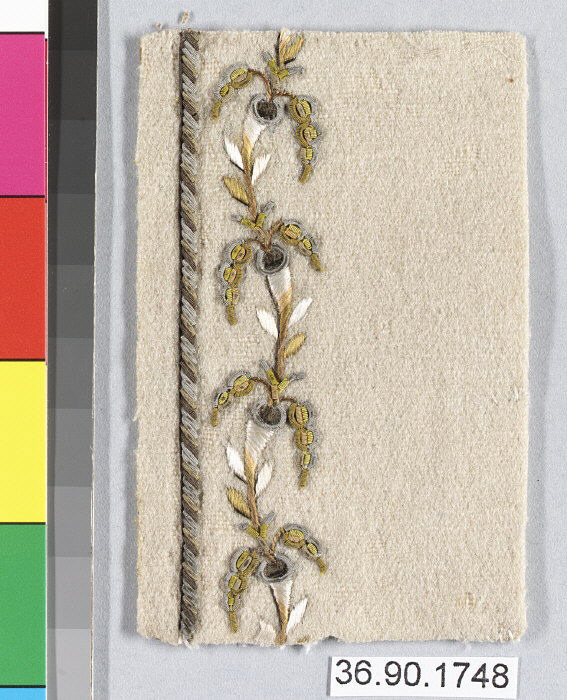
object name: sample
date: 1801-1833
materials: felt, metal thread, silk